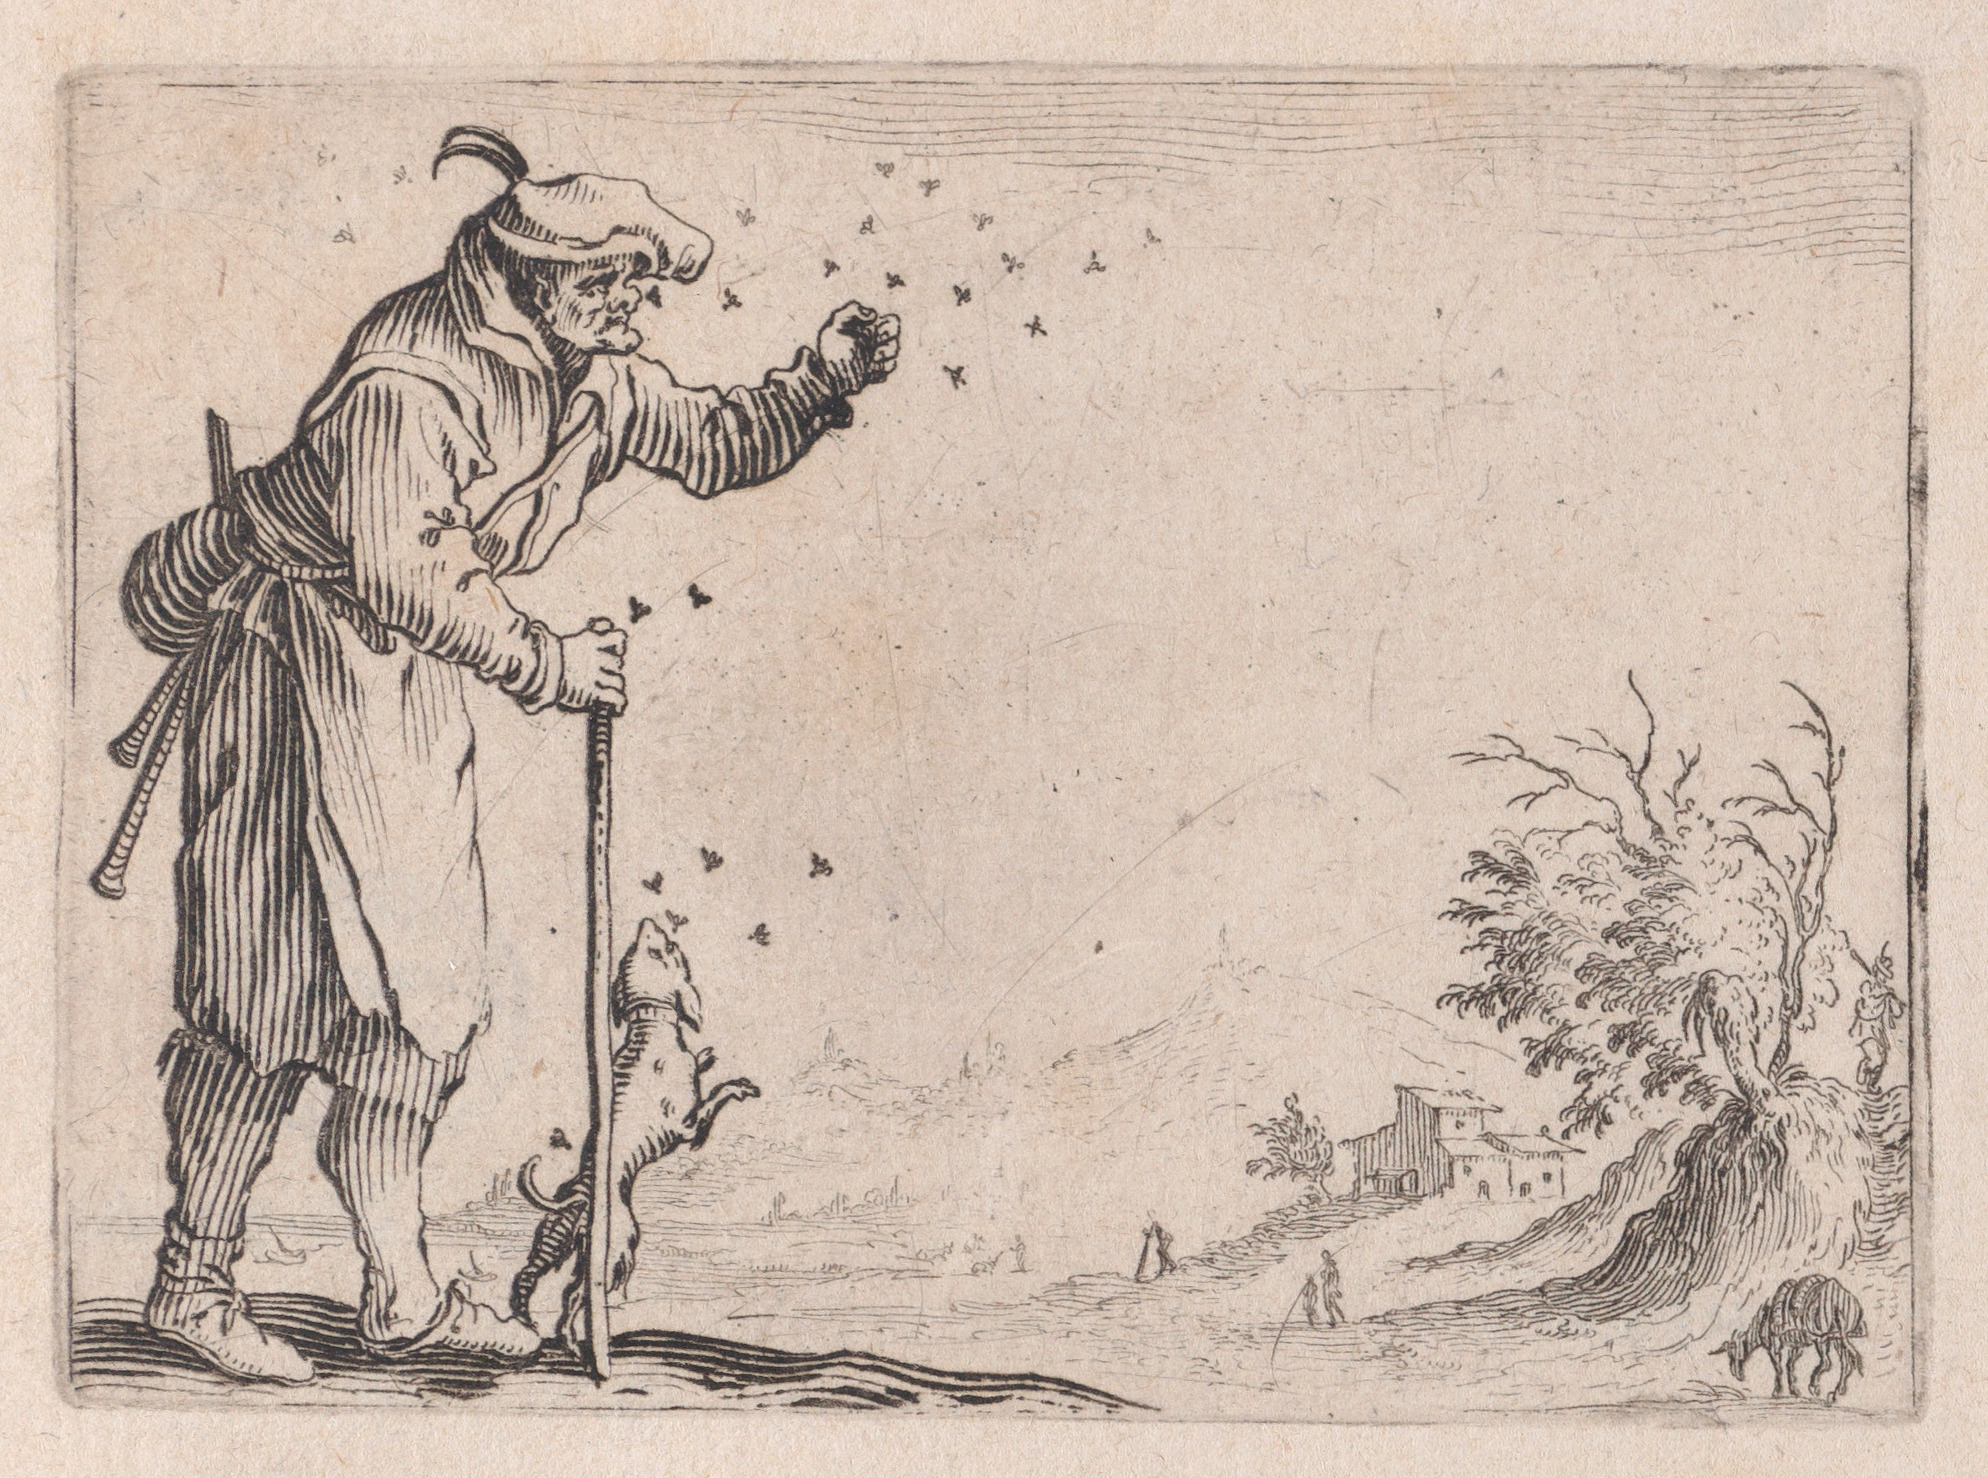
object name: print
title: Le Paysan Assailli par les Abeilles (The Peasant Attacked by Bees), from "Les Caprices" Series B, The Nancy Set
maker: jacques callot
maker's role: artist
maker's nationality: french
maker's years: 1592-1635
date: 1617-1620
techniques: etching